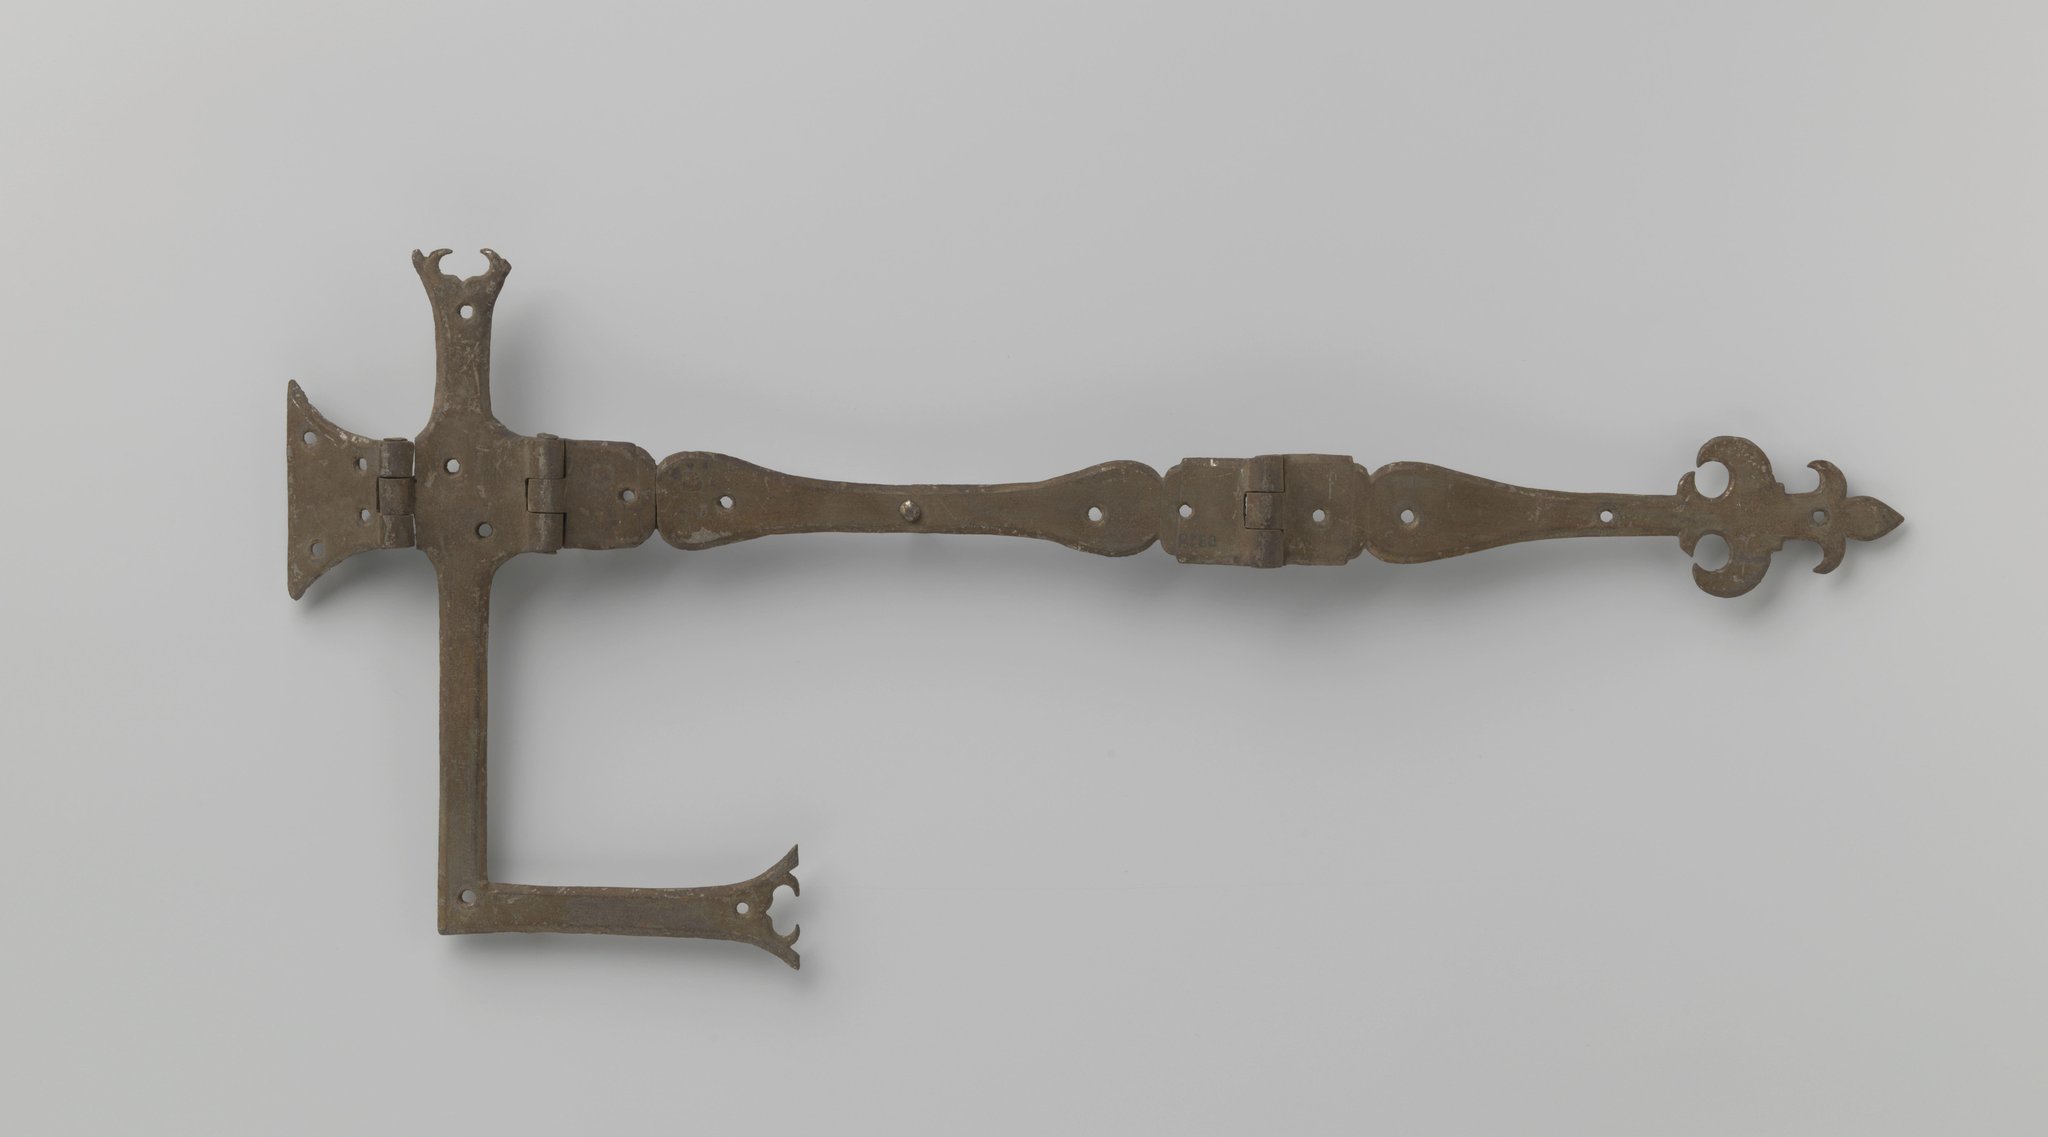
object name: beslag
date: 1400-1950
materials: iron